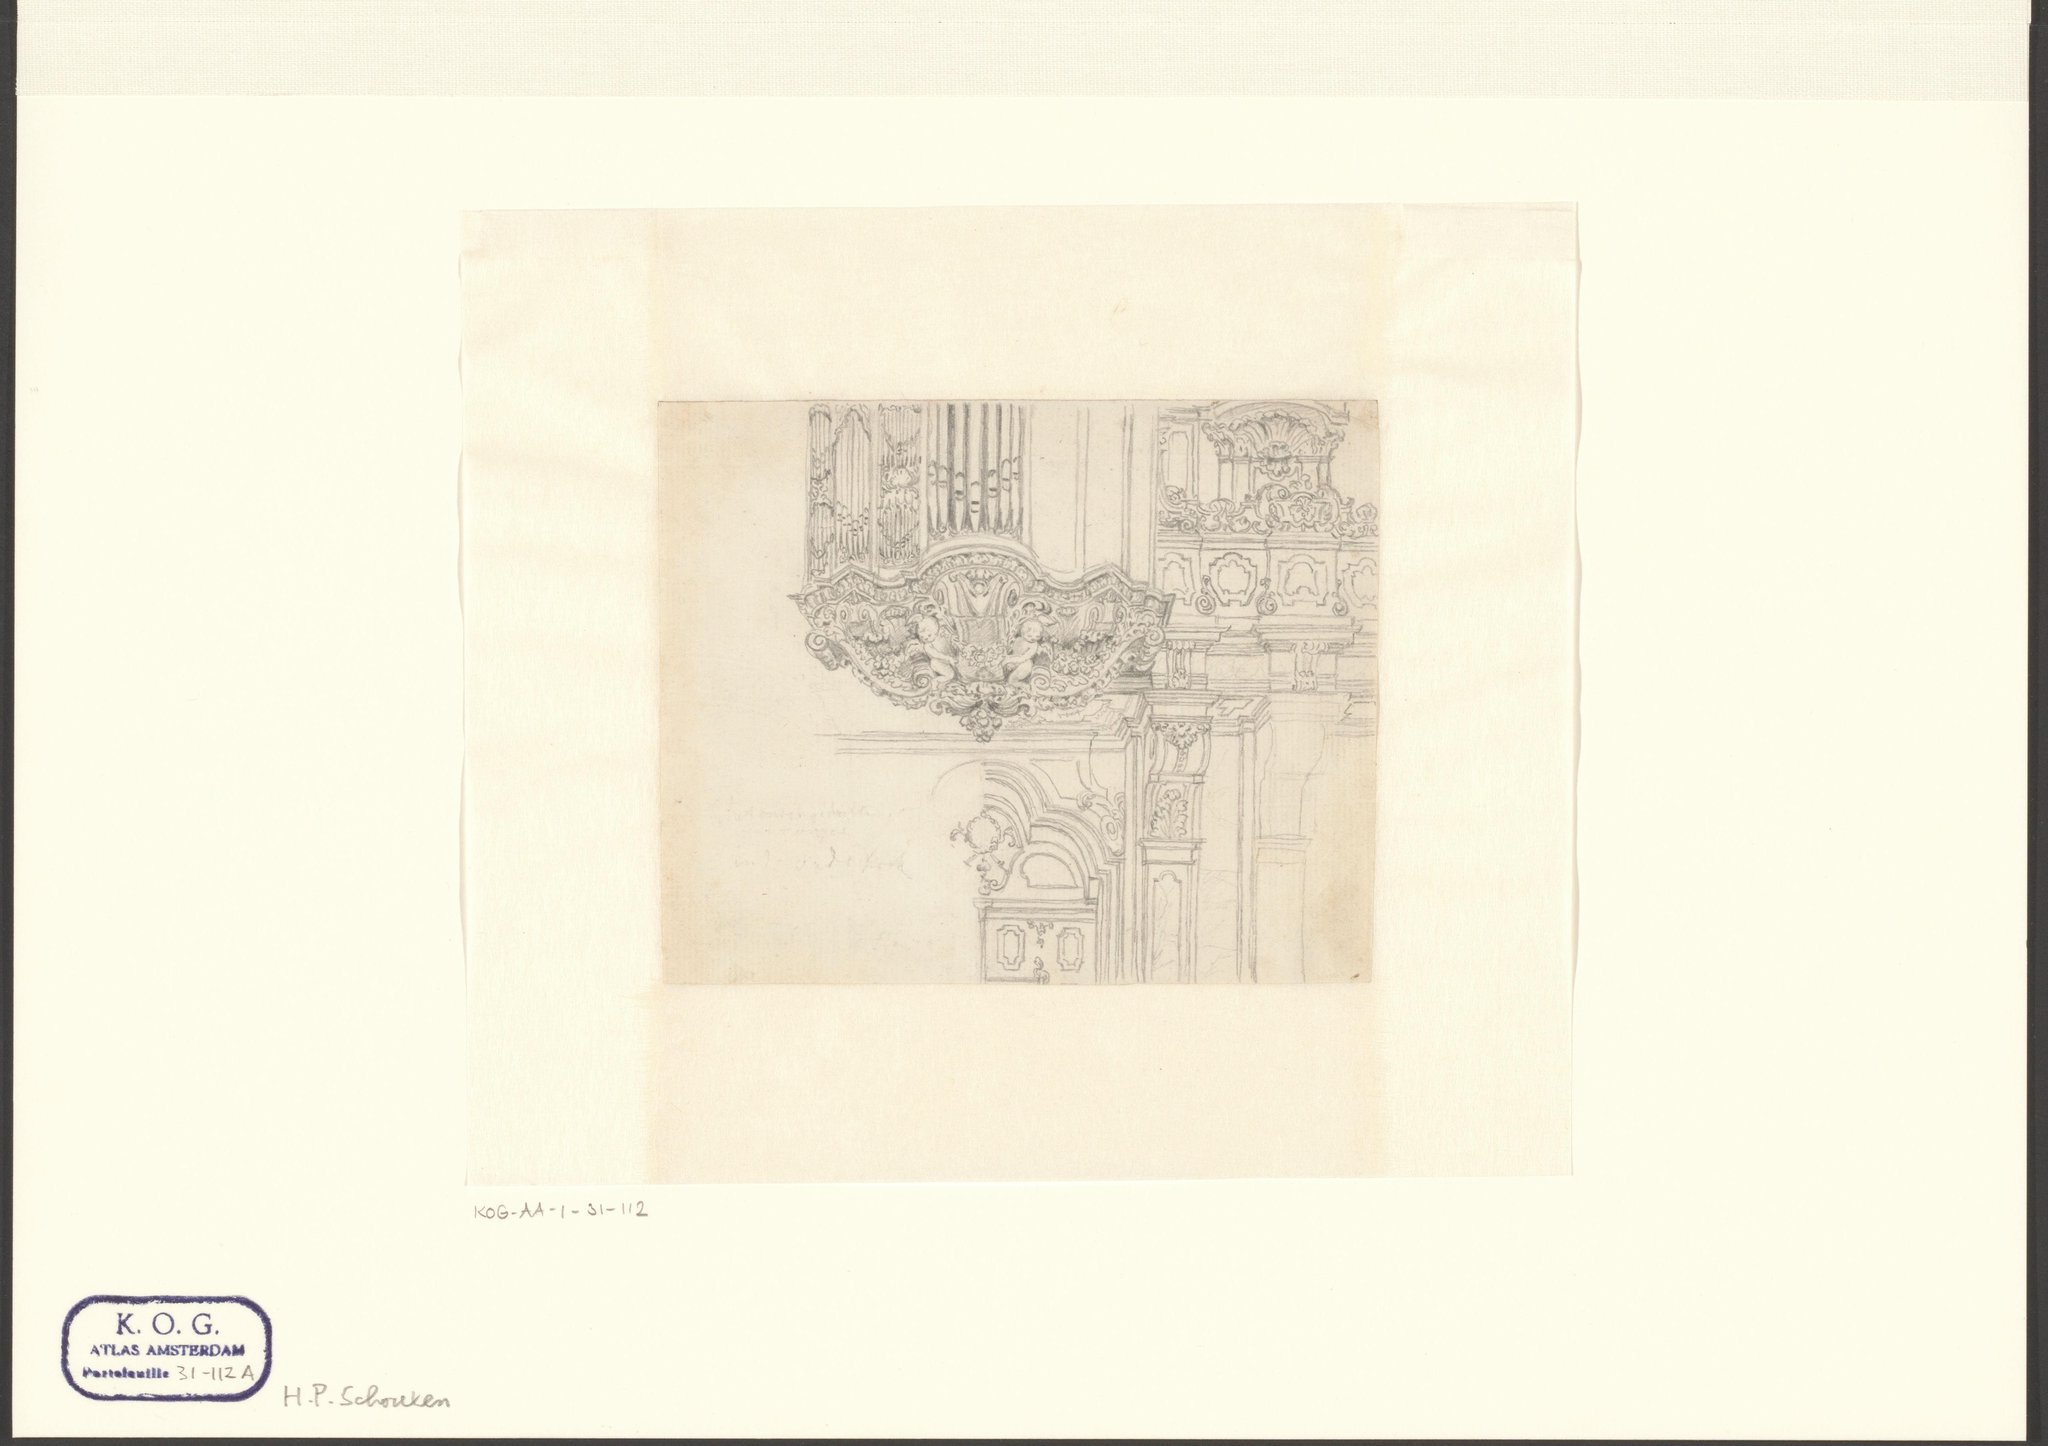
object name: drawing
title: Gezicht op de ingang van de Oude Kerk onder het orgel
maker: gerrit lamberts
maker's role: bookseller, draughtsman, print maker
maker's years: 1776-1850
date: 1786-1850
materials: paper, pencil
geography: amsterdam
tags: gate, entrance, church organ, interior of church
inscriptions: inscription: ‘31.112A’, inscription: ‘het oude [...] / t orgel / in de oude kerk’, collector's mark: ‘31-112A’ Lugt 1641b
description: Onderwerpsrubriek binnen de Atlas Amsterdam: Oude Kerk van binnen.